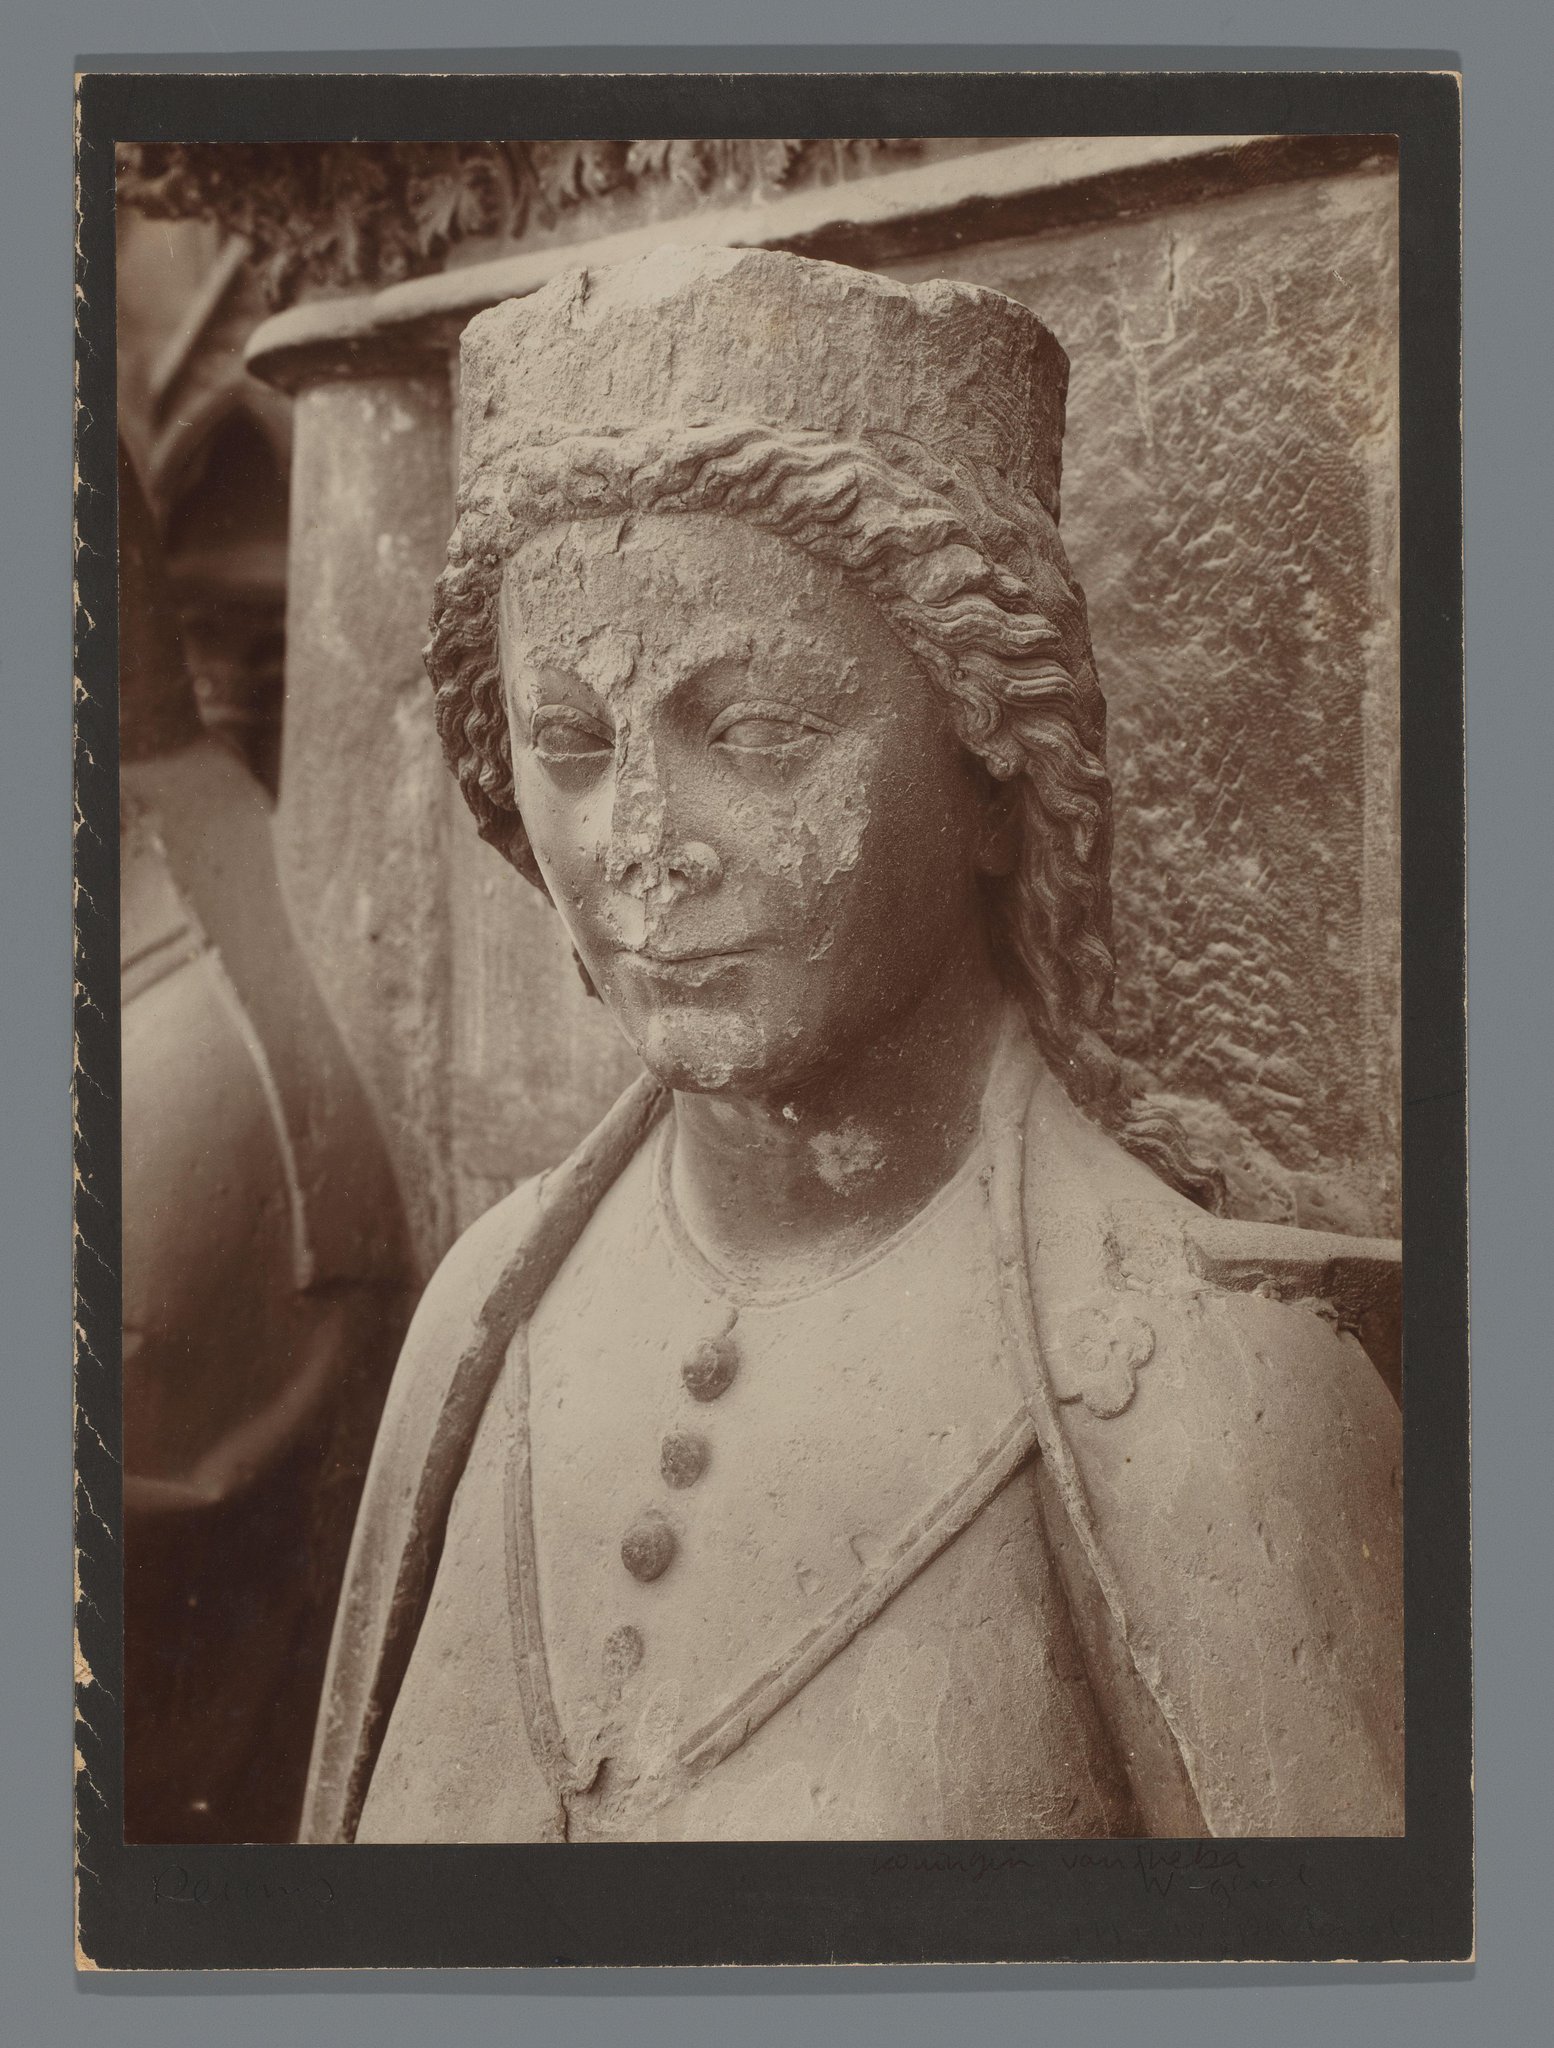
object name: photograph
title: Frankrijk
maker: Anonymous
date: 1850-1880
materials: photographic support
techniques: albumen print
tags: france